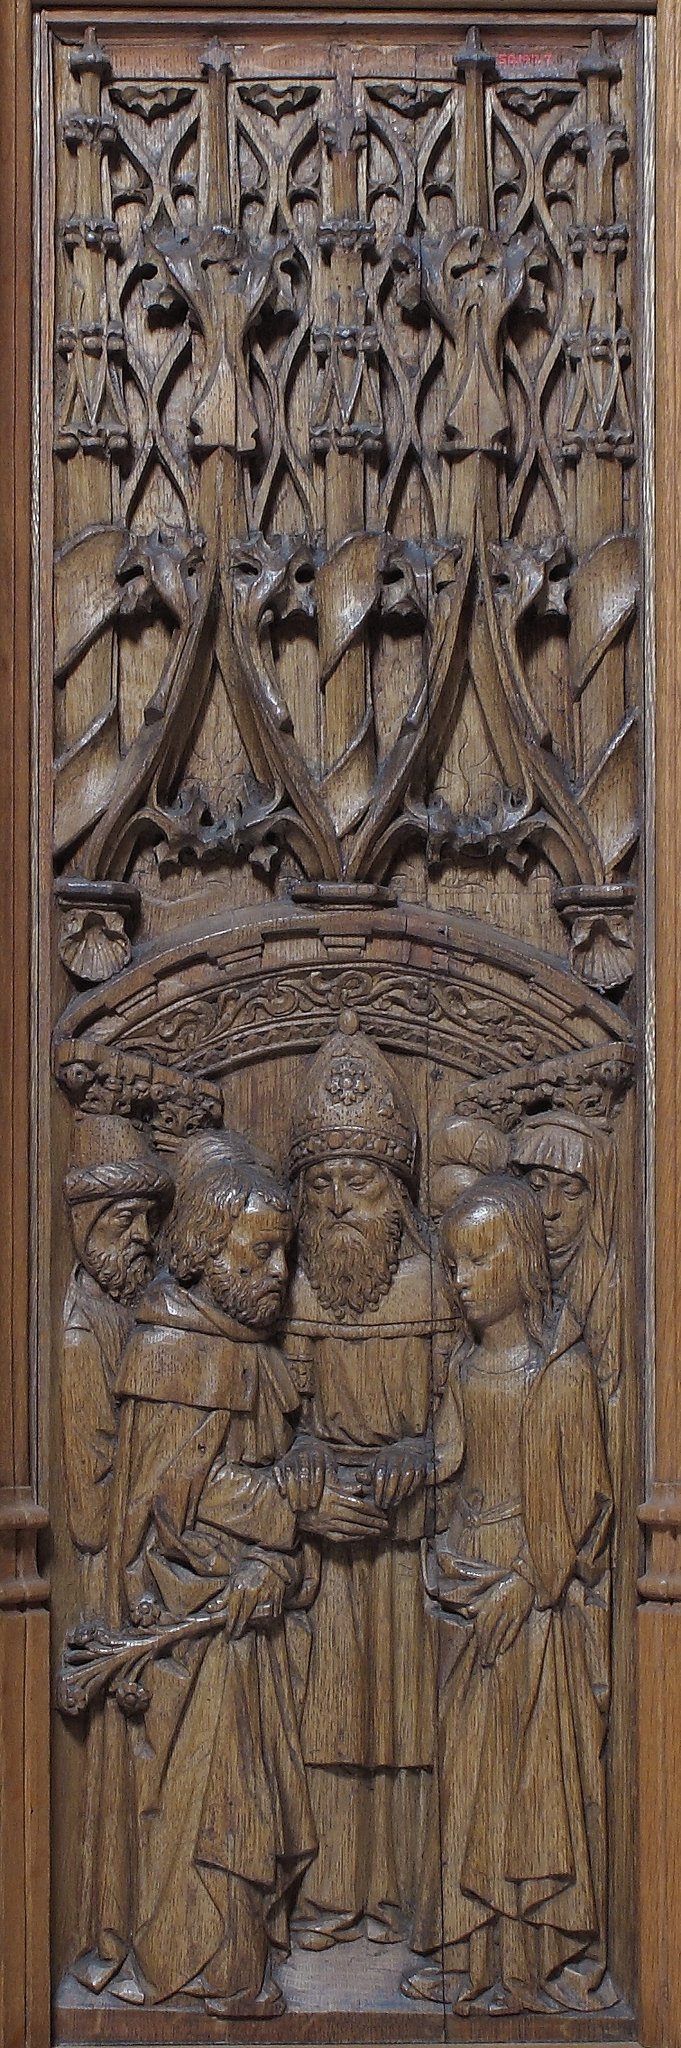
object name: panel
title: Panel with the Marriage of the Virgin and Joseph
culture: french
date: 1501-1533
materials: wood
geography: france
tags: men,virgin mary